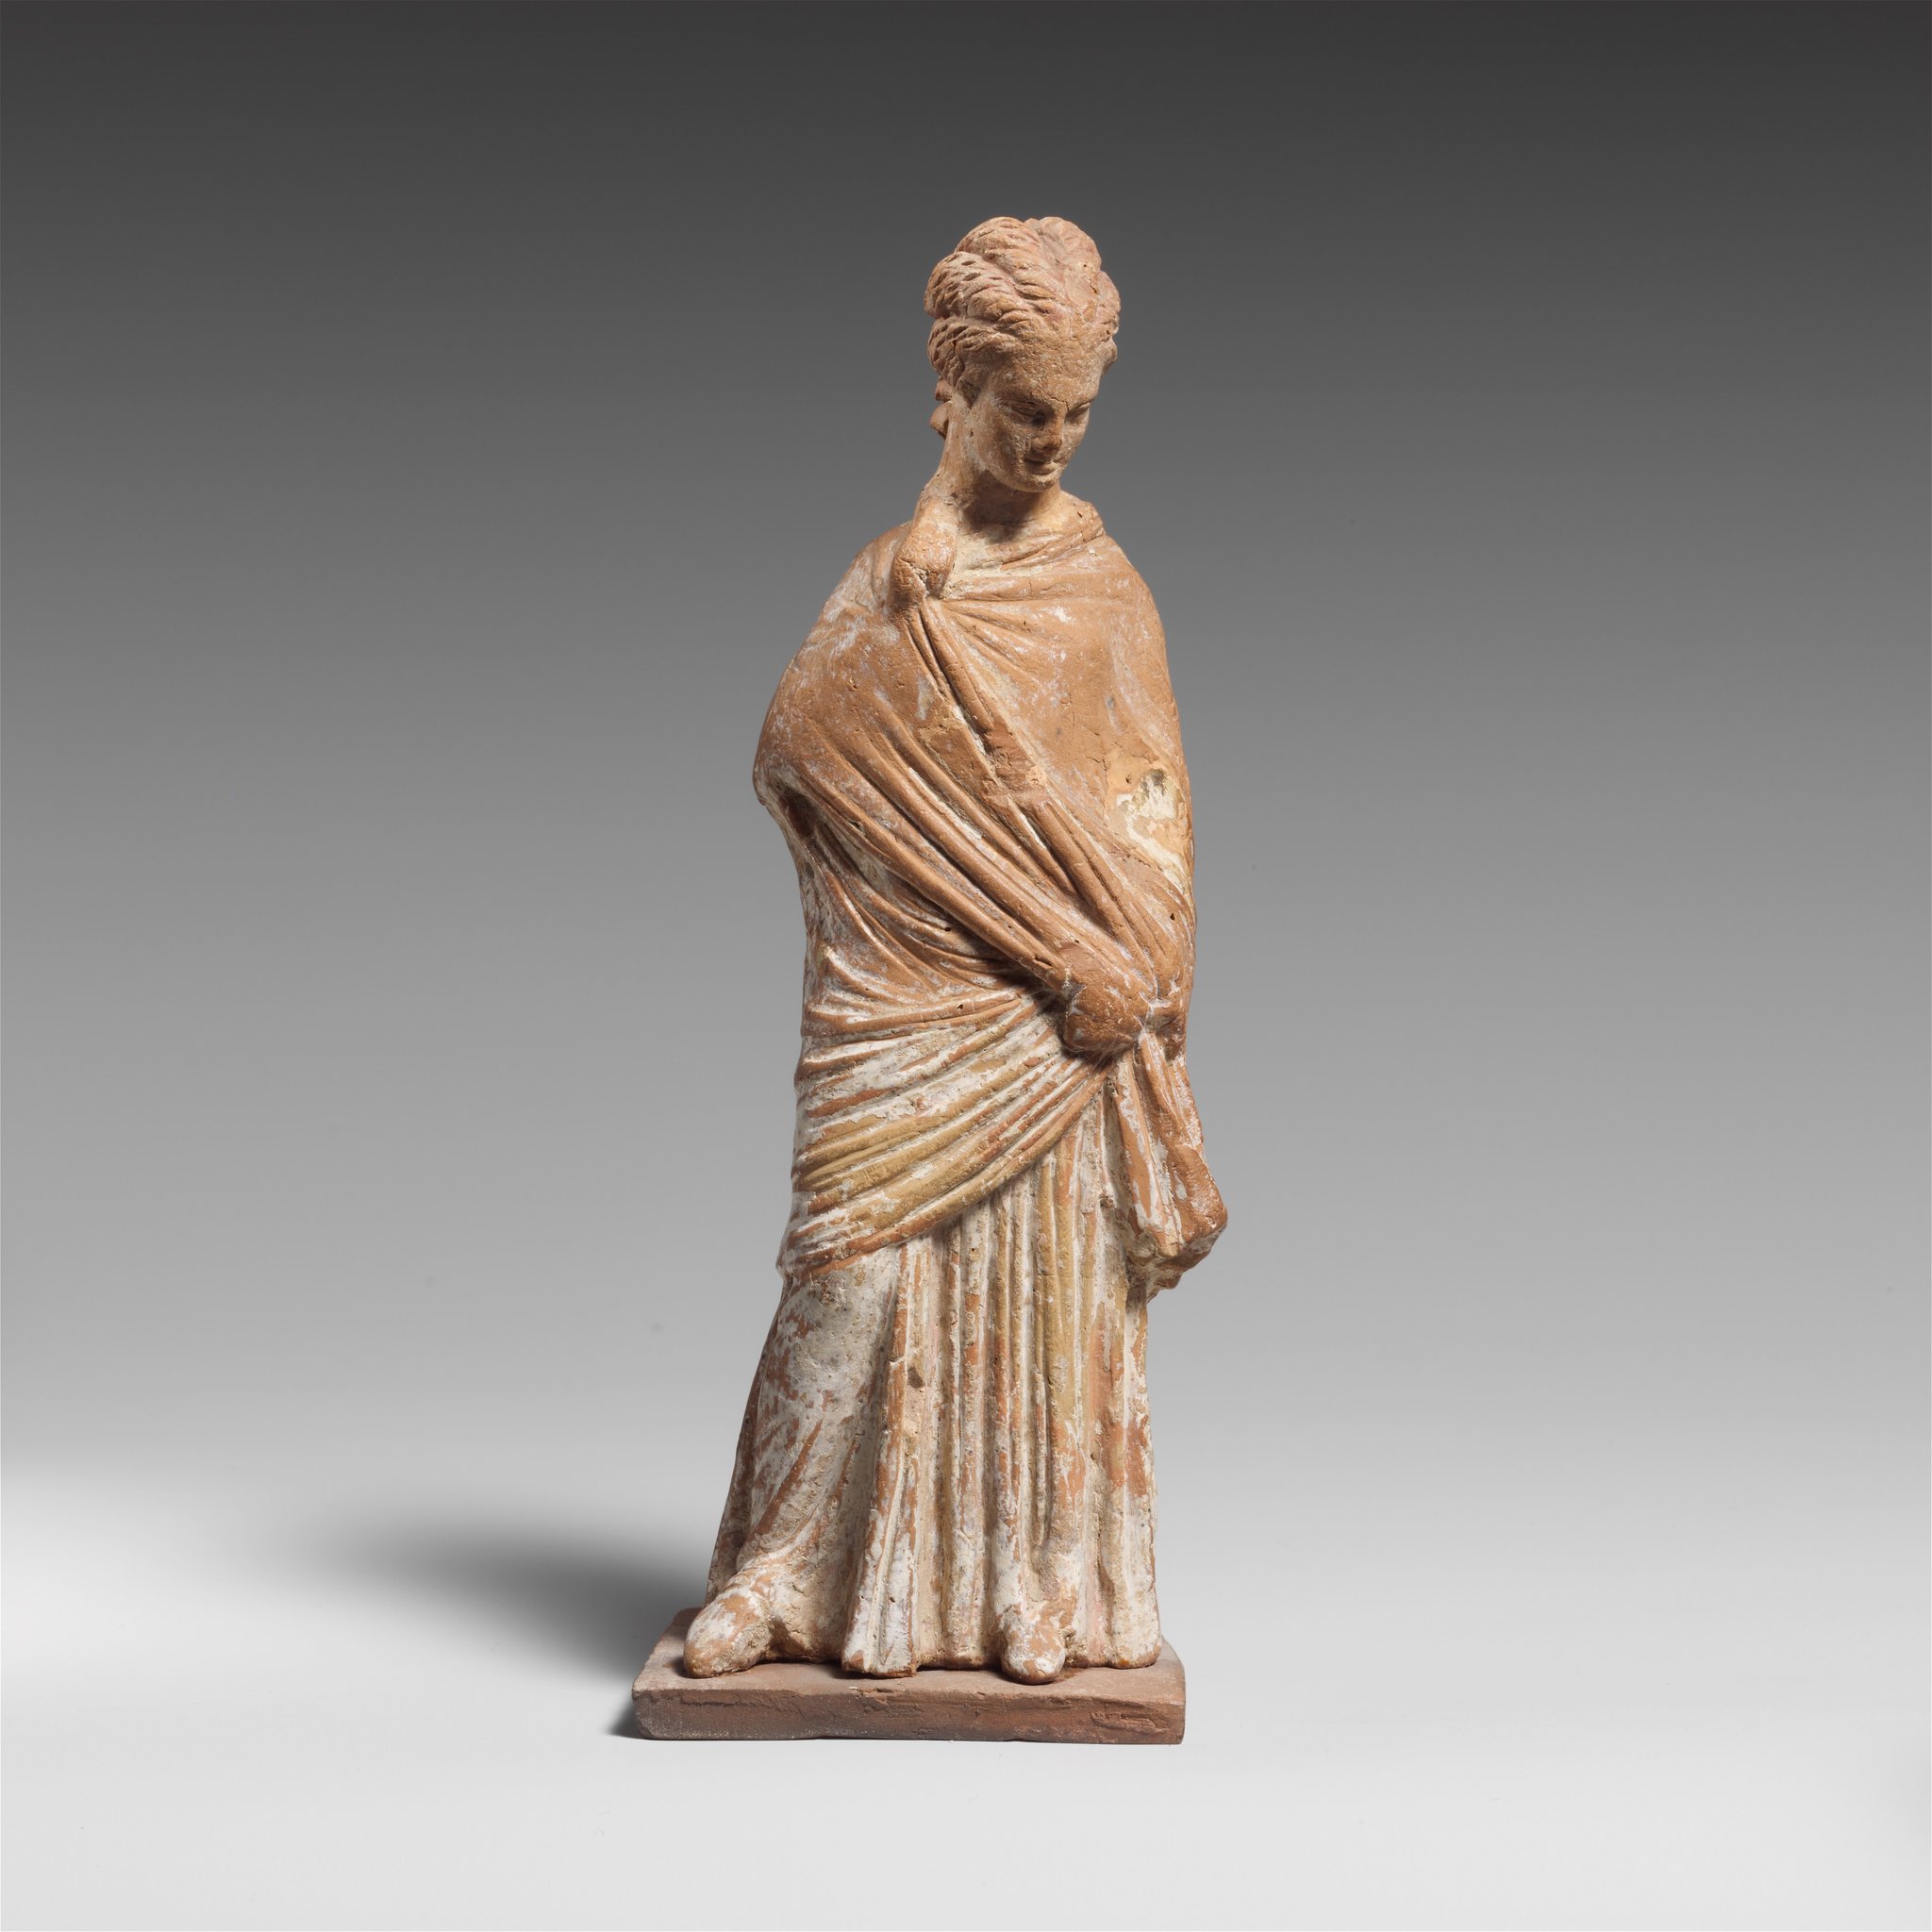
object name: statuette of a woman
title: Terracotta statuette of a draped woman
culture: greek, boeotian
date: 300-201 BCE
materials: terracotta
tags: women